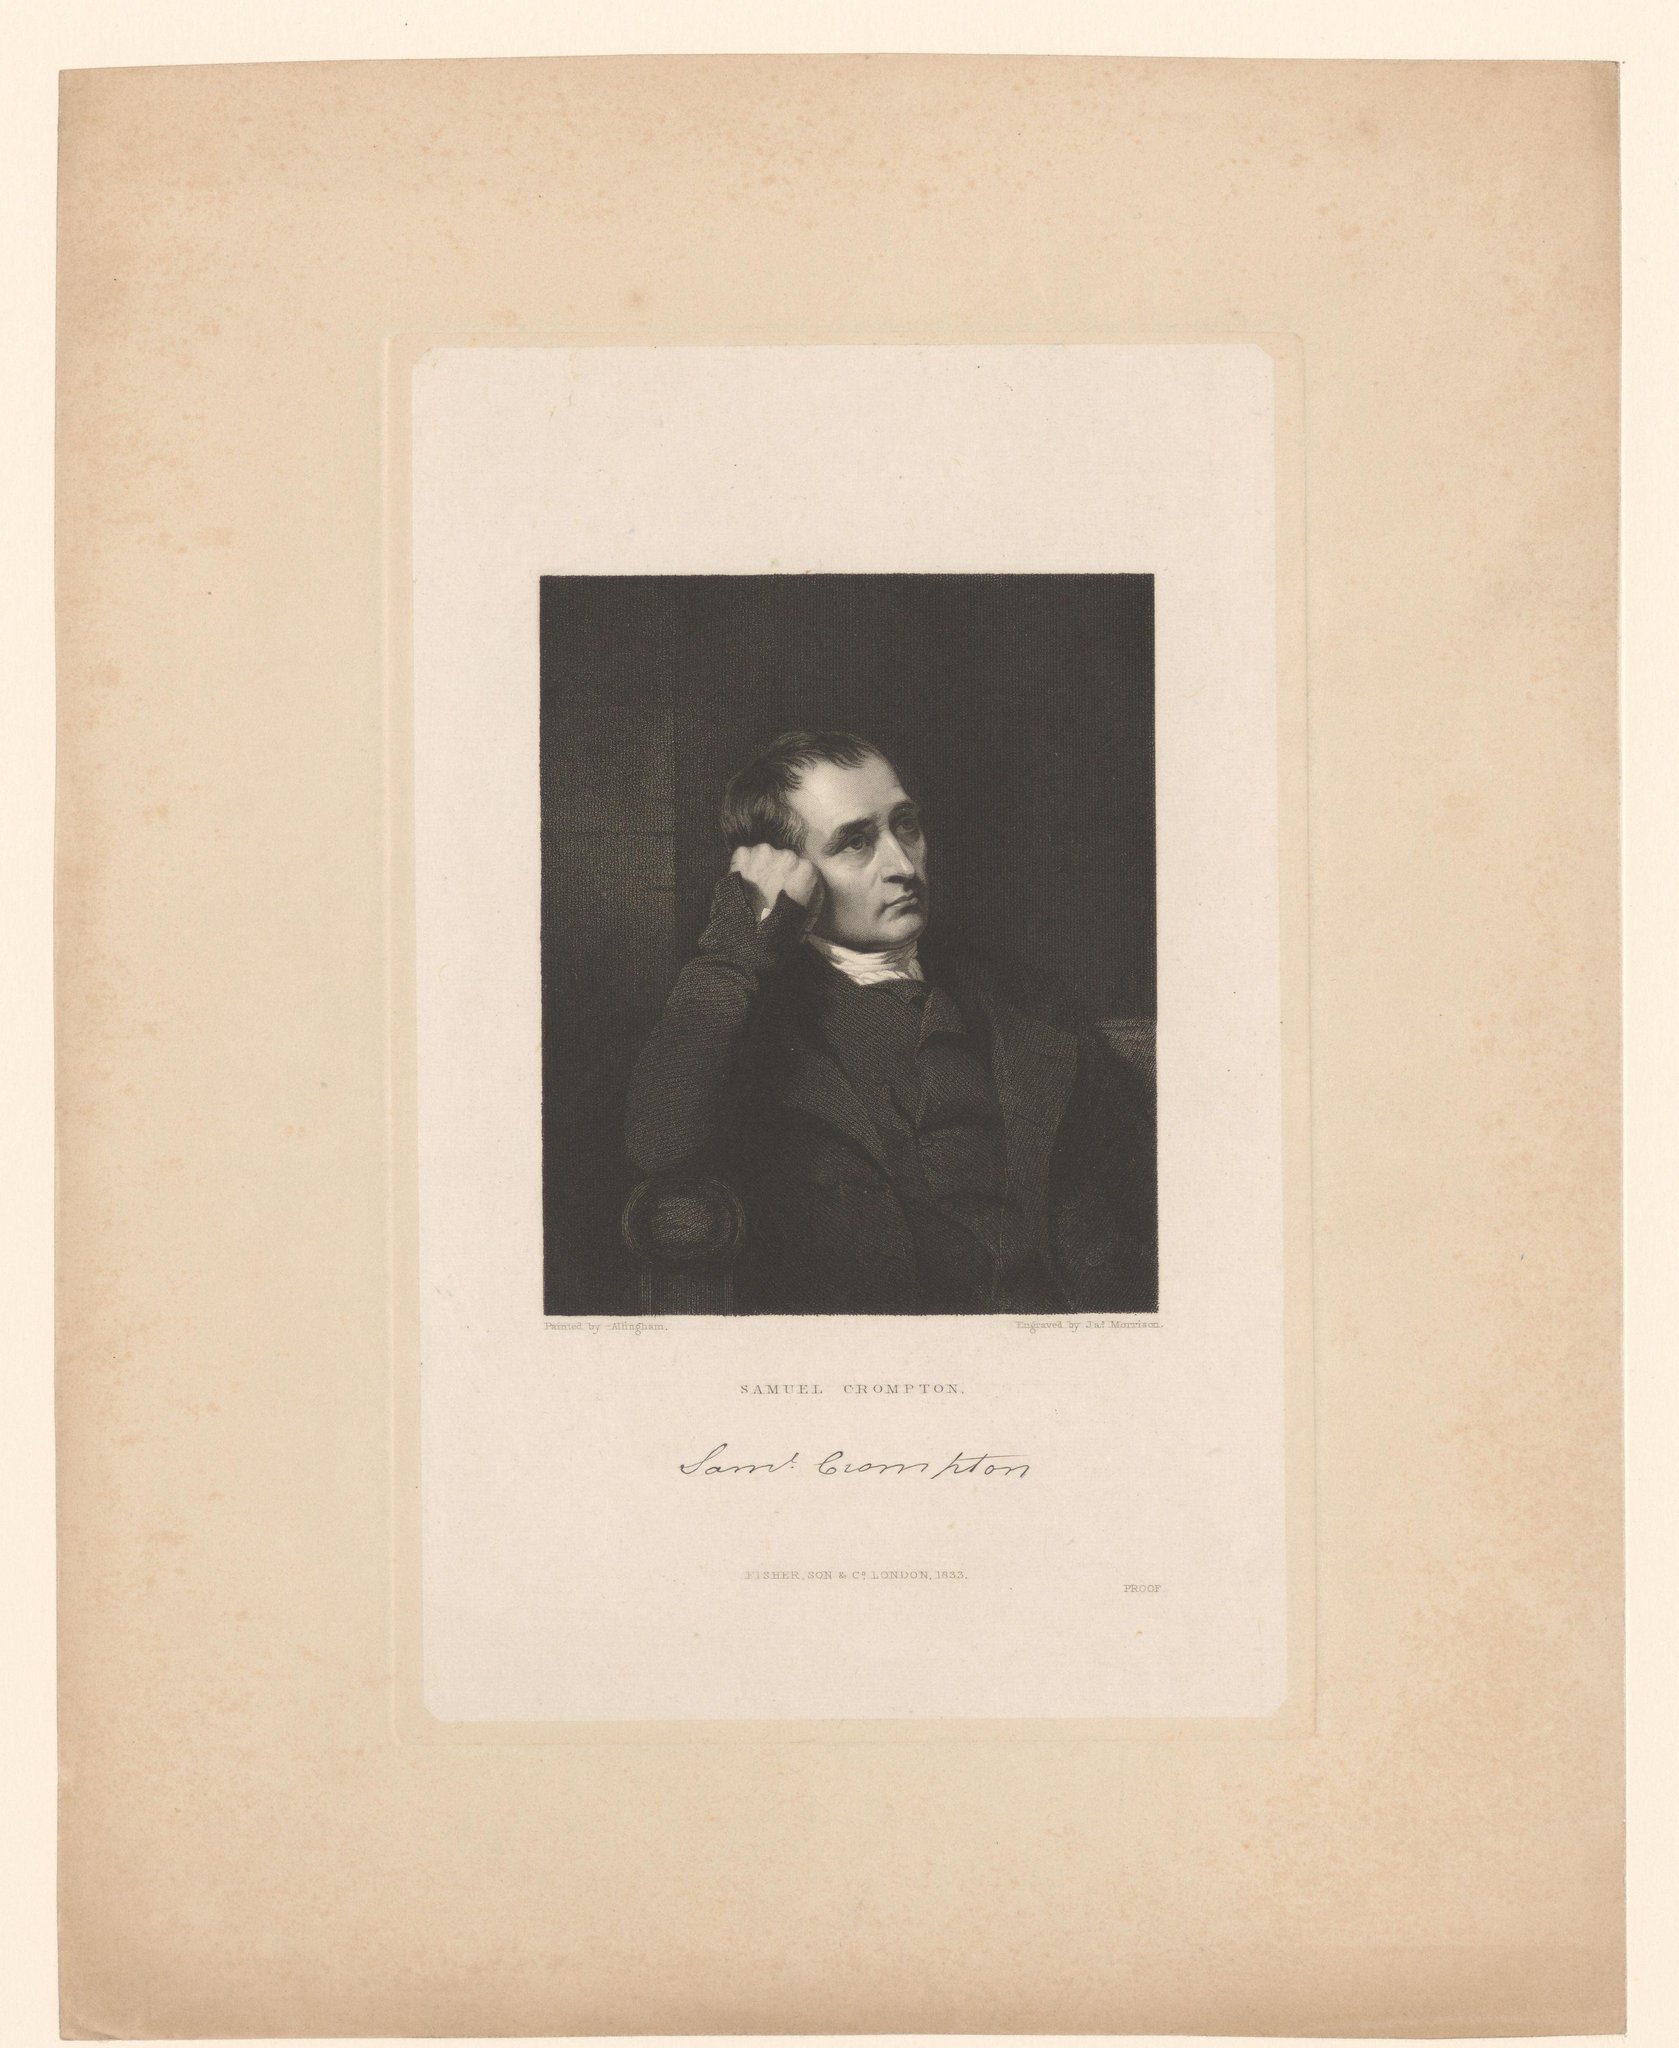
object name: print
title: Samuel Crompton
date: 1833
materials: paper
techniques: engraving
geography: london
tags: engineering (+ portrait of scholar, scientist), historical persons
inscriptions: collector's mark: Lugt 2228